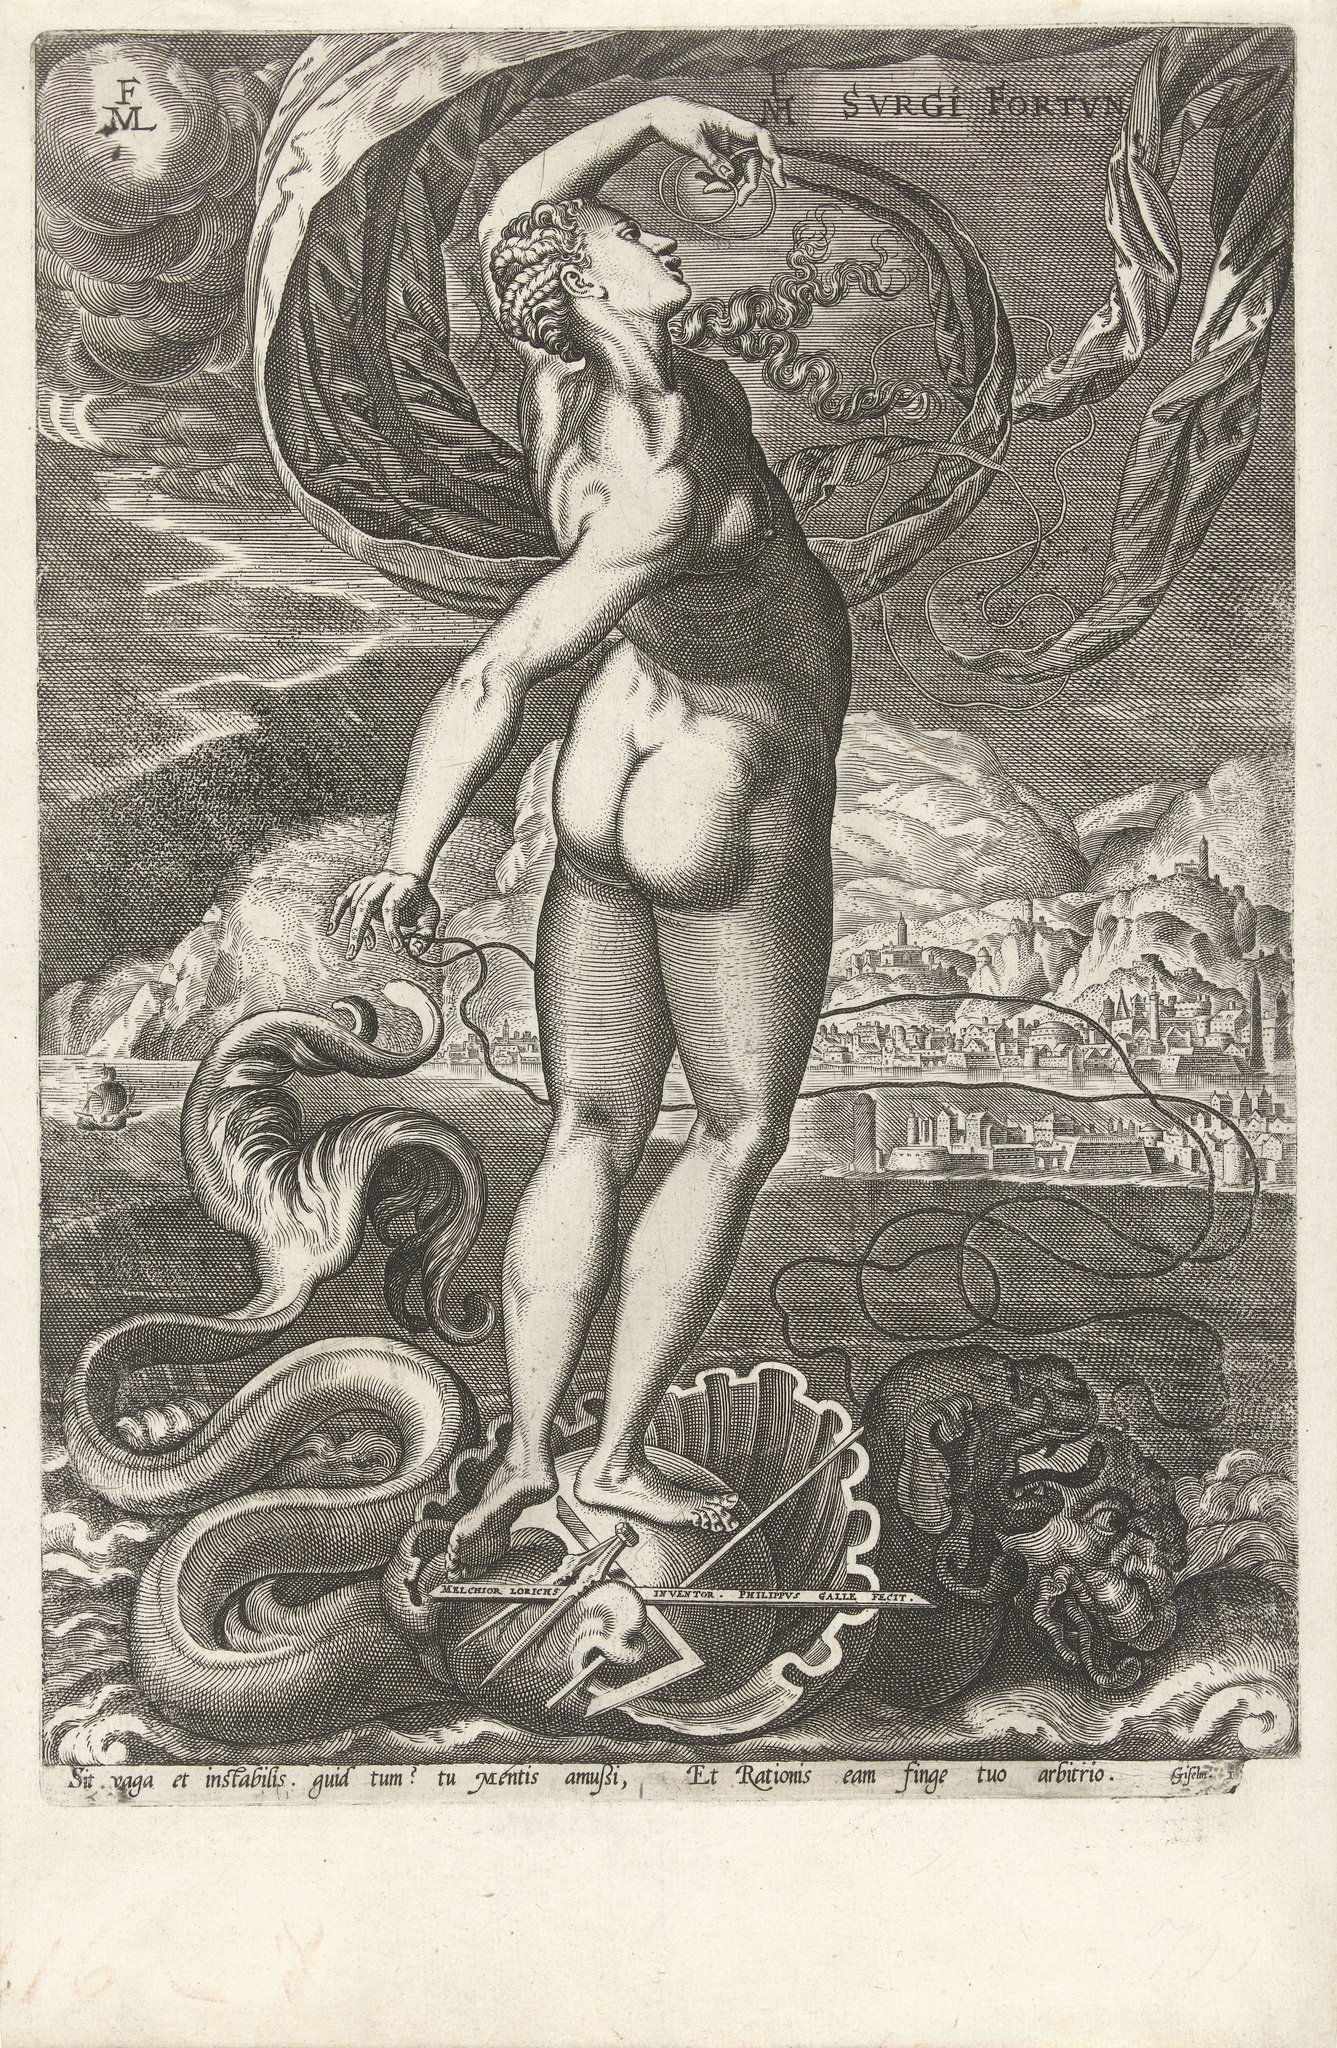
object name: print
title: Svrgi Fortvn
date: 1574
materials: paper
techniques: engraving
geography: antwerp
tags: luck, fortune, lot; 'fato', 'fortuna', 'fortuna aurea', 'fortuna buona', 'fortuna pacifica overo clemente', 'sorte' (ripa), swimming mammals: seal - ff - fabulous animals (sometimes wrongly called 'grotesques'); 'mostri' (ripa)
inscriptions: collector's mark: Lugt 2760, collector's mark: Lugt 2228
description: De personificatie van het Lot. Ze staat wankel op een bolvormige sfeer, die in een schelp op zee drijft. In haar handen een zeil, waarmee ze vaart naar gelang welke kant de wind waait. Naast de schelp twee zeehonden. De prent heeft een Latijns onderschrift.